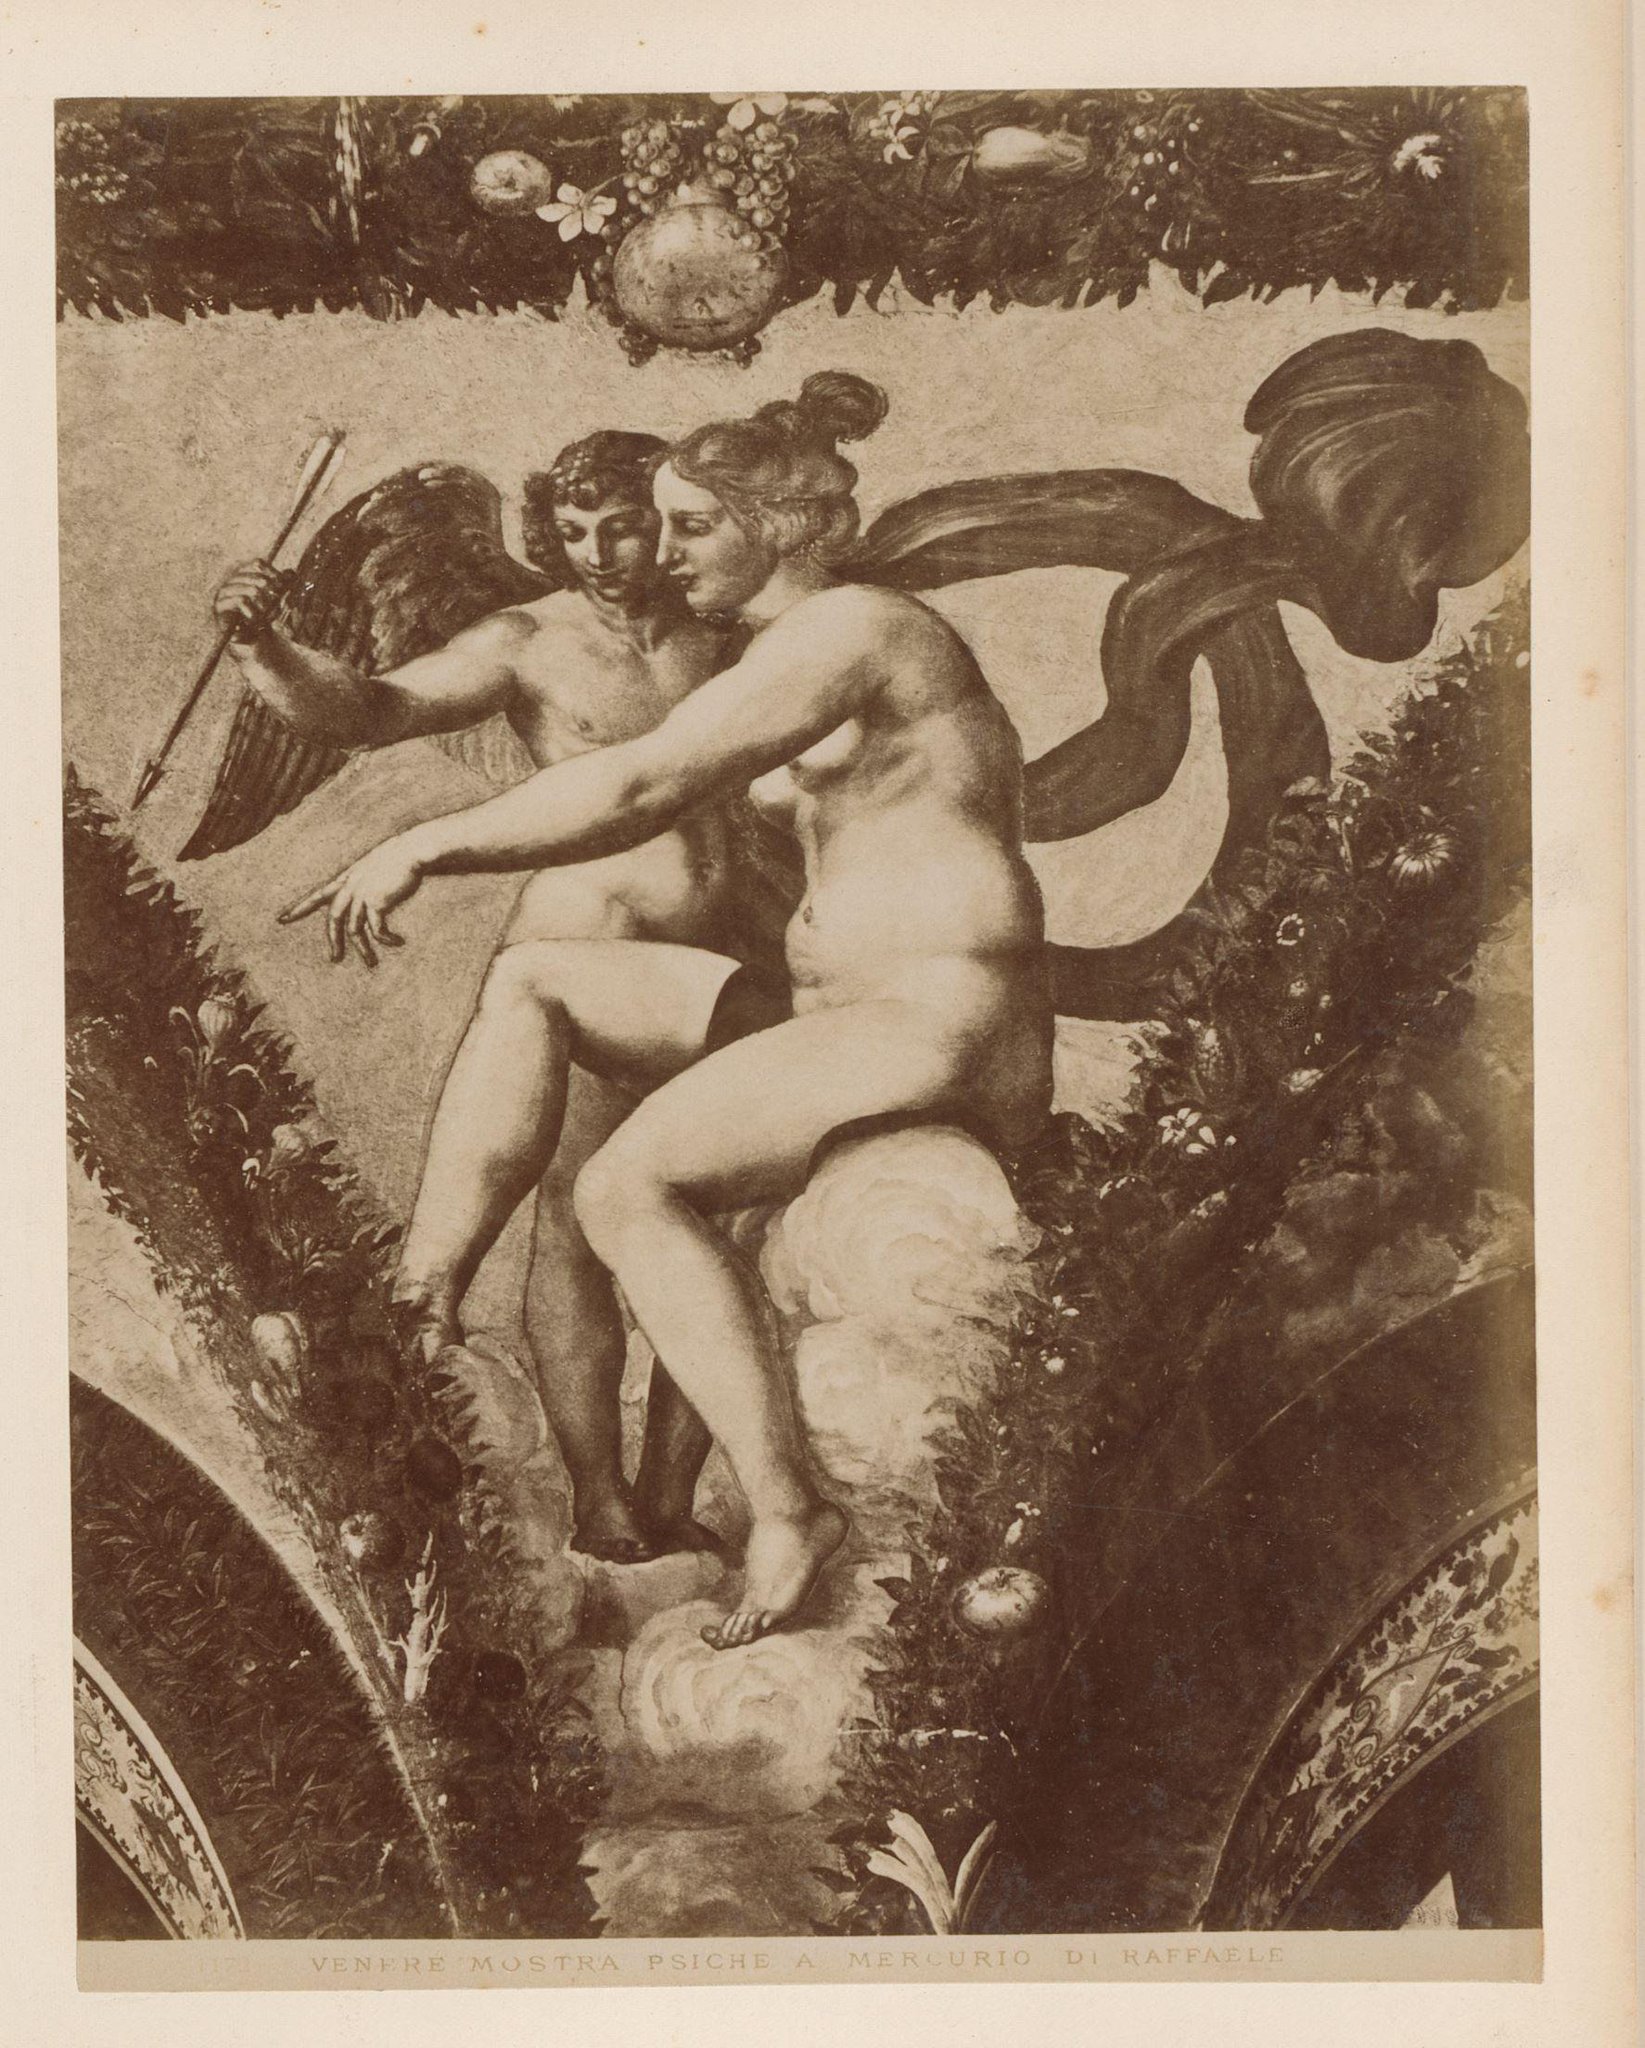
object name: reproduction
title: Fotoreproductie van fresco Venus en Psyche door Rafaël in het Farnesina te Rome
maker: domenico anderson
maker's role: fotograaf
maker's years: 1854-1939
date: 1870-1890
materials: paper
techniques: albumen print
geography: villa farnesina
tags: picture, painting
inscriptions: inscription: ‘1172 VENERE MOSTRA PSICHE A MERCURIO DI RAFFAELE’